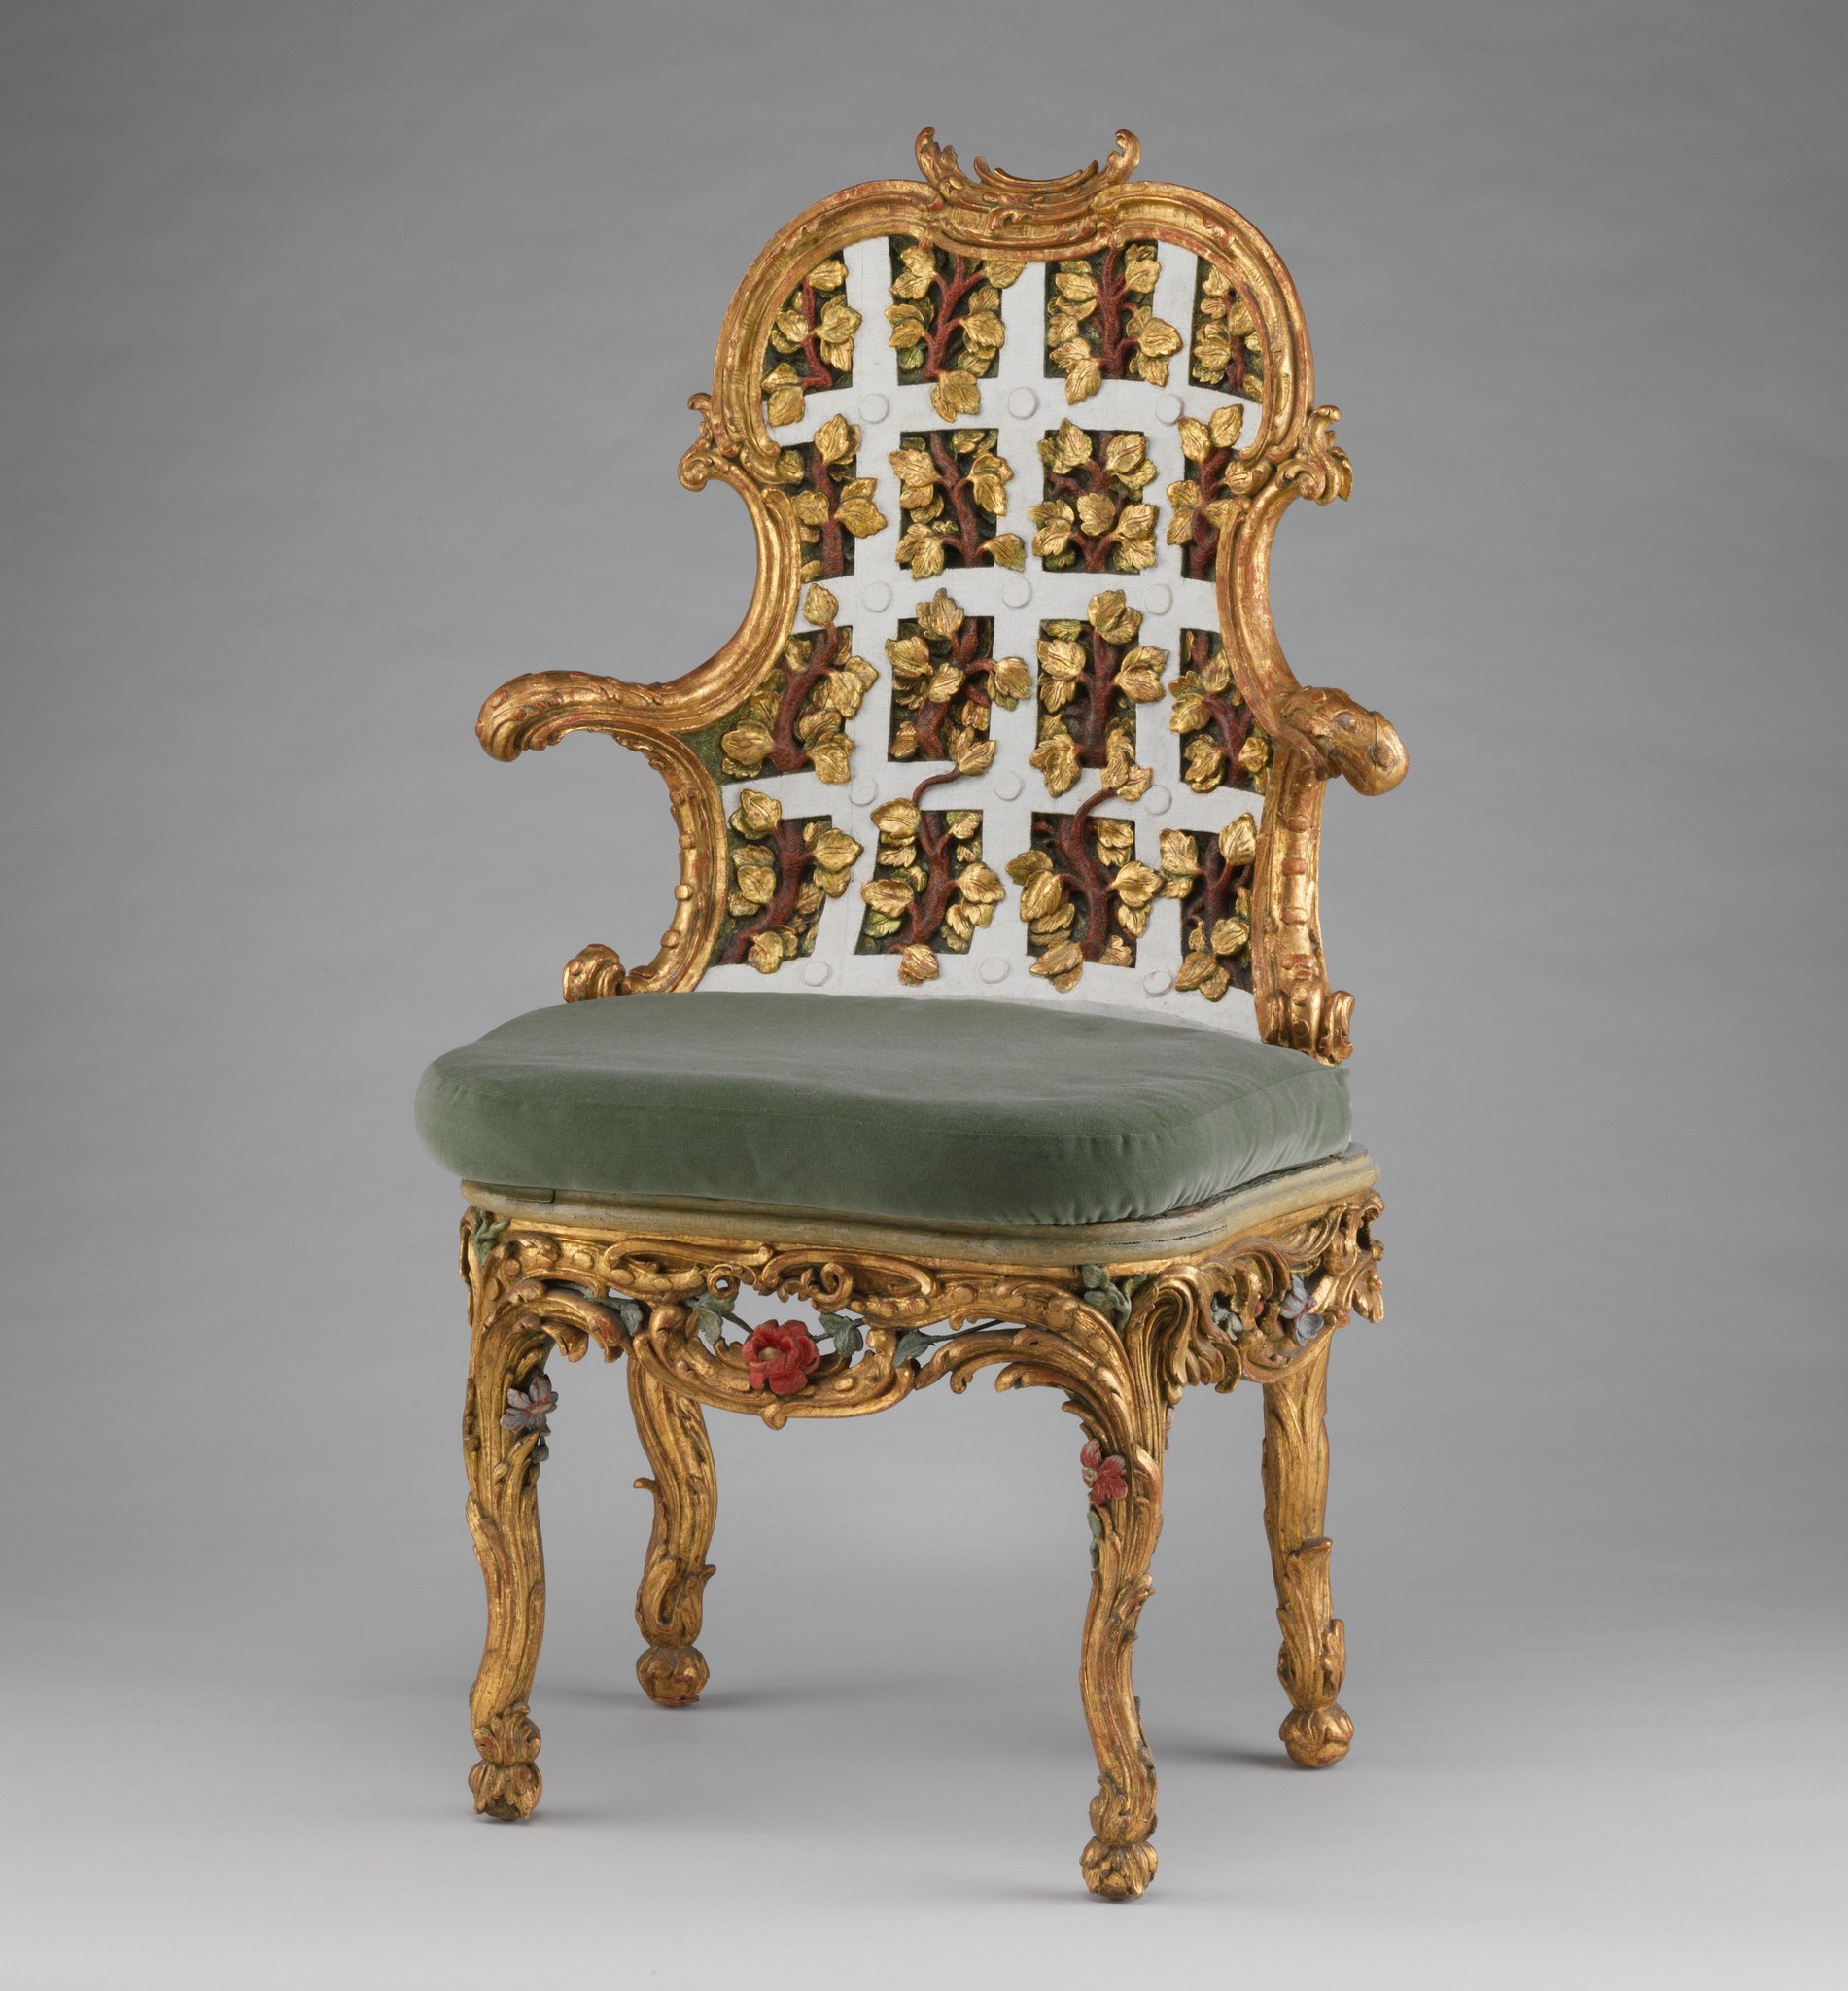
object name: armchair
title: Armchair (one of a pair) (part of a set)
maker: johann michael bauer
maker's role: maker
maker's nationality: german, born westheim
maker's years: 1710-1779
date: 1763-1764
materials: silk, velvet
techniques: carving, gilding, painting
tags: flowers